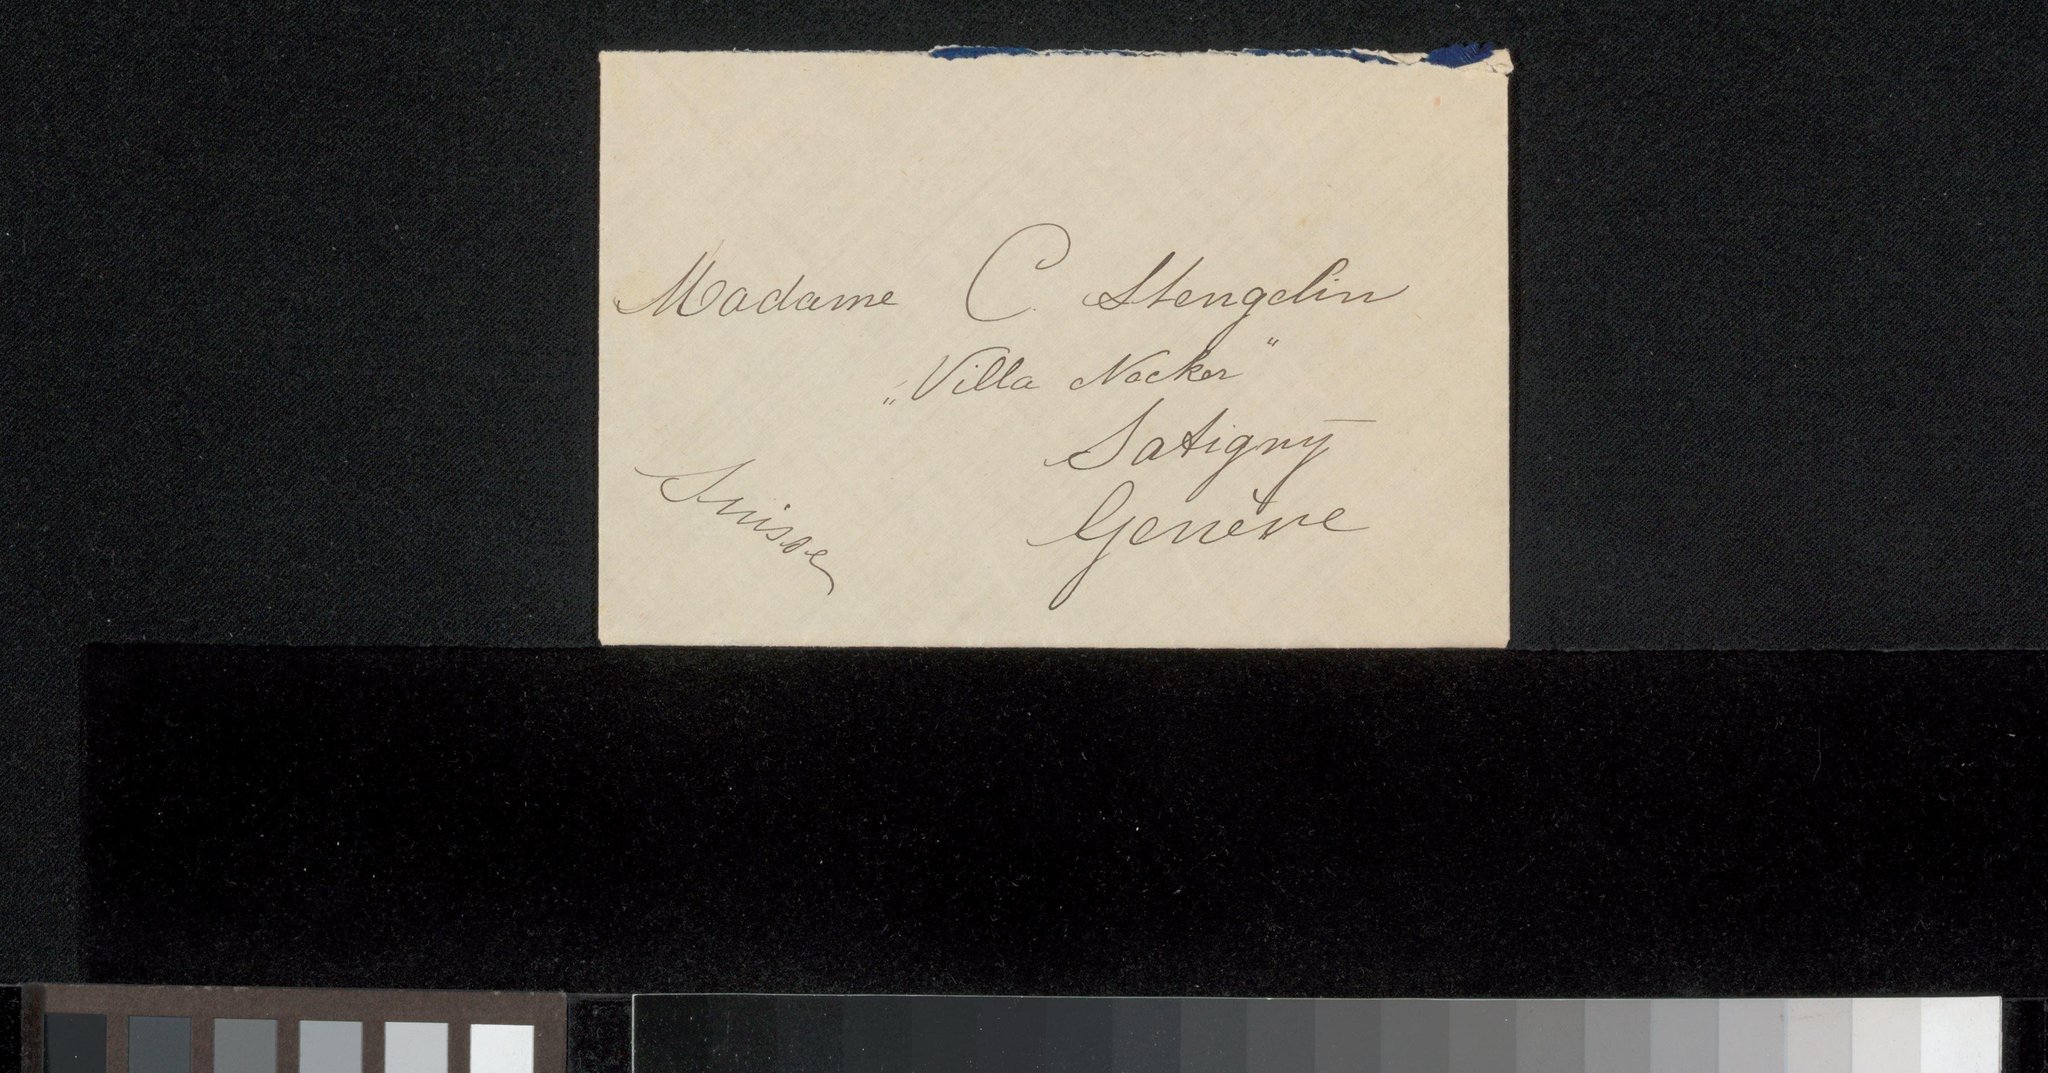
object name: envelope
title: Envelop aan mevrouw C. Stengelin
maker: Anonymous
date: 1982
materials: ink, paper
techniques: pen, writing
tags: c. stengelin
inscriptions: collector's mark: ‘RPK’